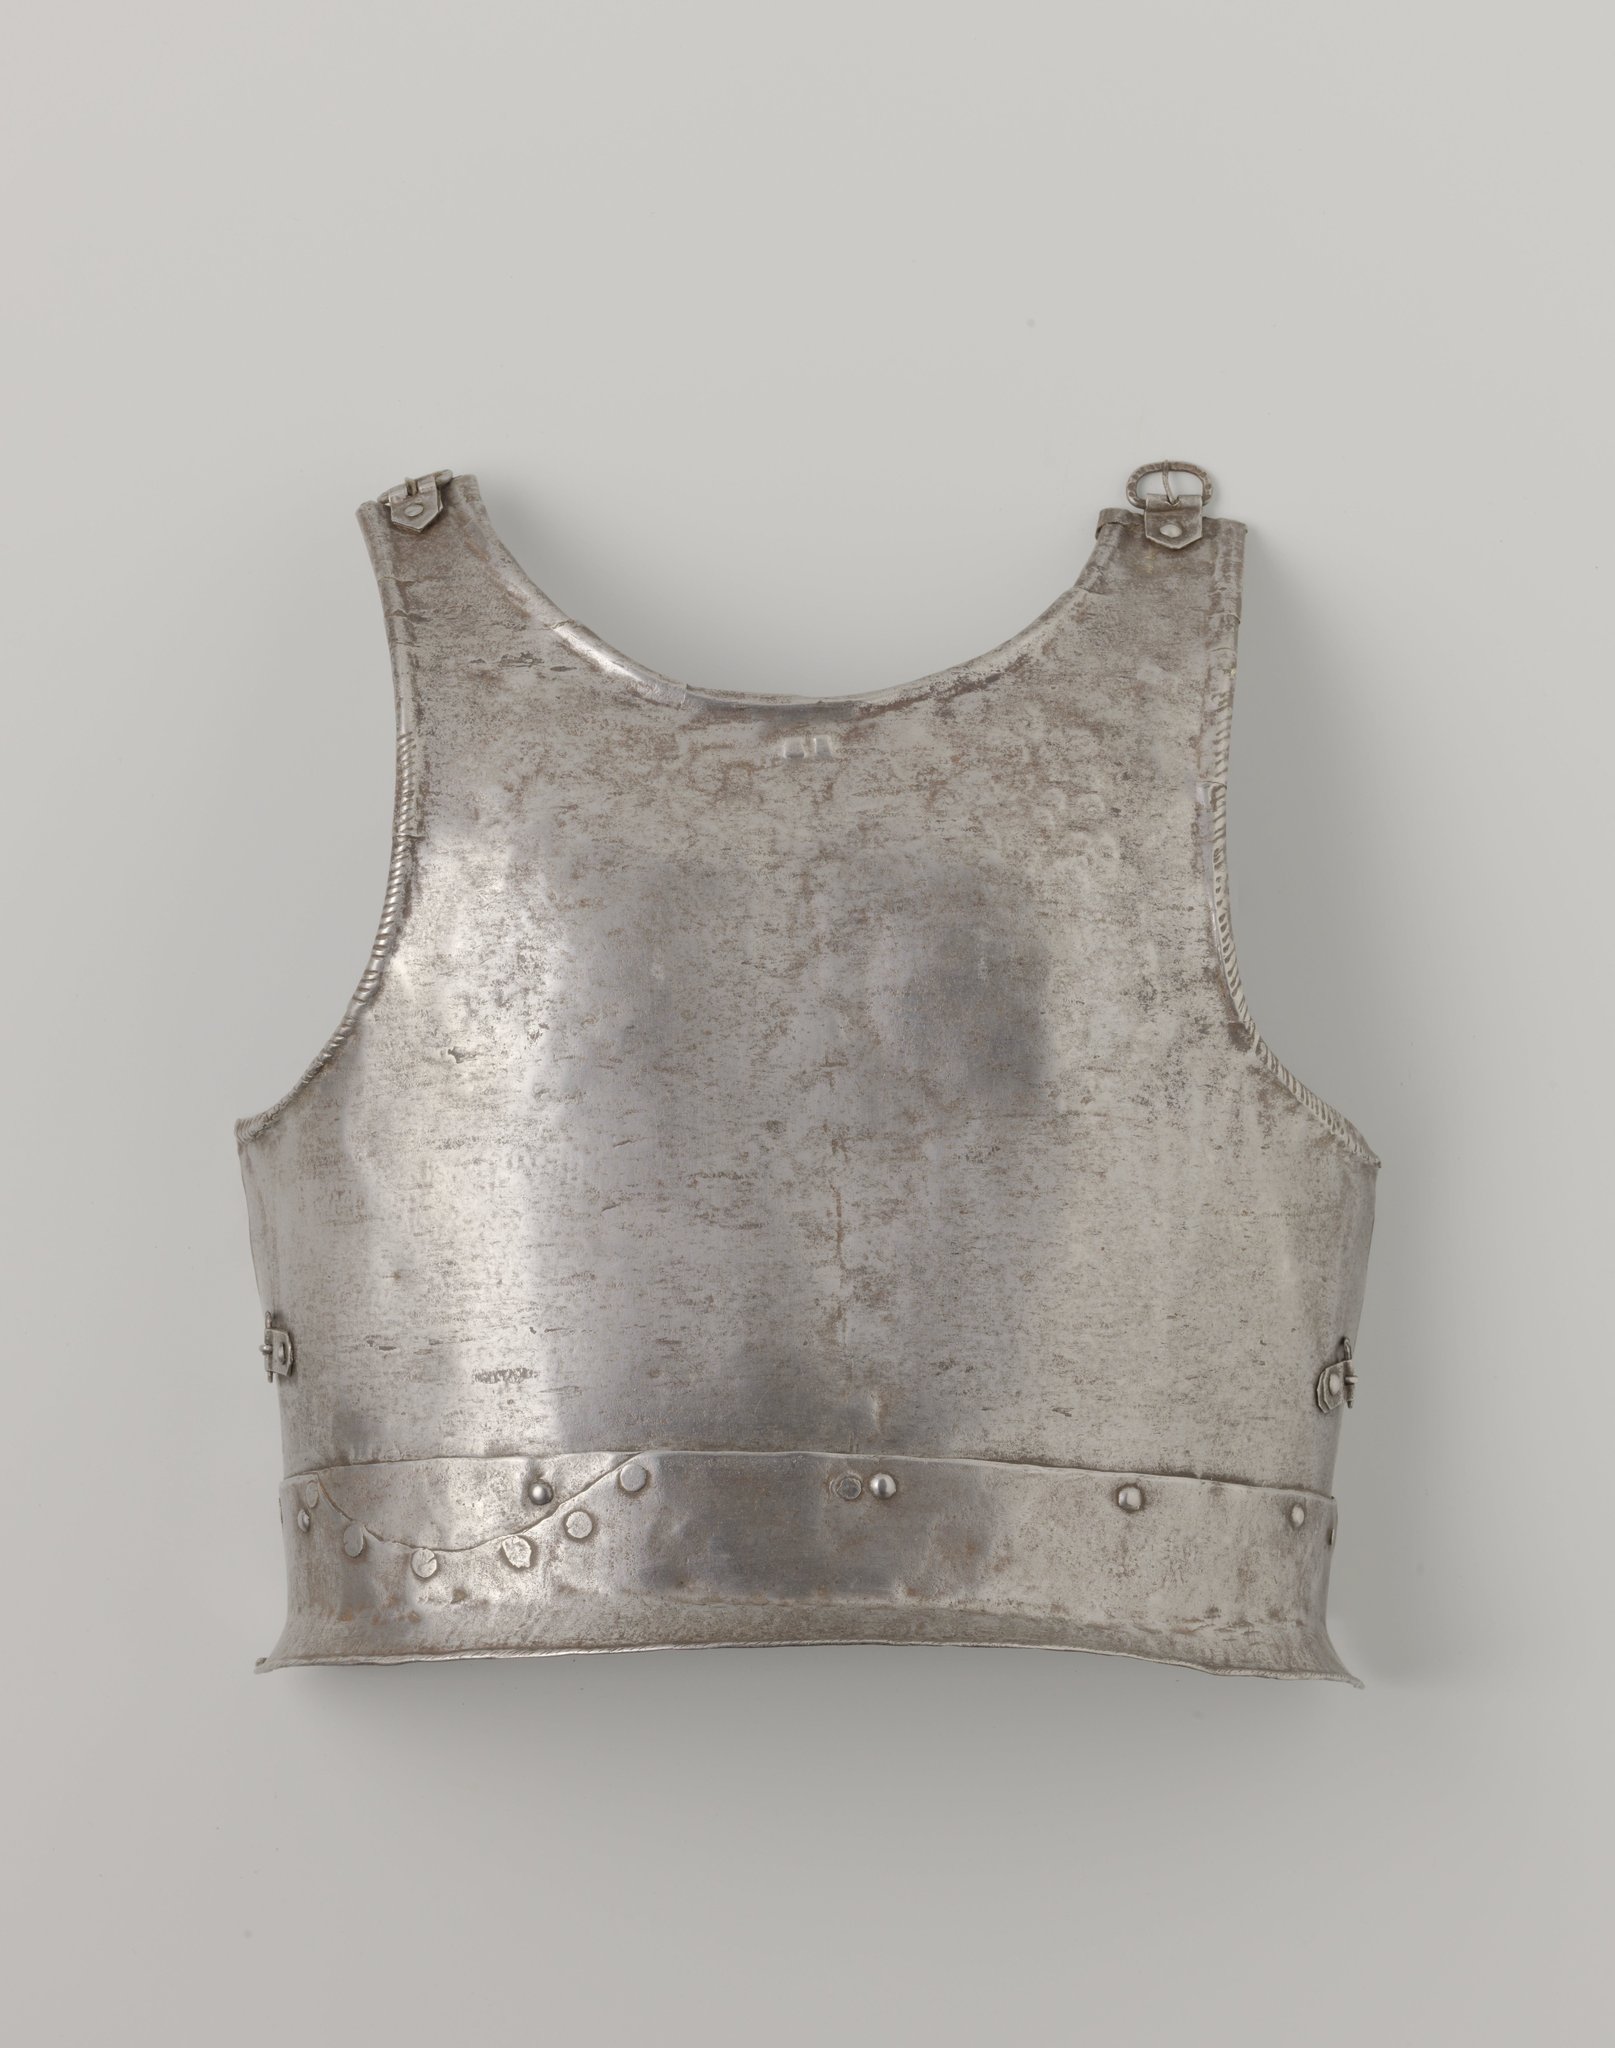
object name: backplate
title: Rugplaat van kuras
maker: Anonymous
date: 1499-1699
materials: iron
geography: europe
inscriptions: : ‘A’, number: ‘4493’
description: Rugplaat van kuras, ijzer, blank, de arm- en nekuitsnijdingen alsmede de onderrand van de lendenstrook hoogstaand gekabeld rondgeflenst. Aan weerzijden van de halsuitsnijding twee ijzeren gespen. Aan de onderzijde van beide armuitsnijdingen twee ijzeren gespen. De lendenstrook is aan de rugplaat vastgeklonken, de linkerzijde is gelapt. De binnenzijde van de rugplaat is zwart geverfd.